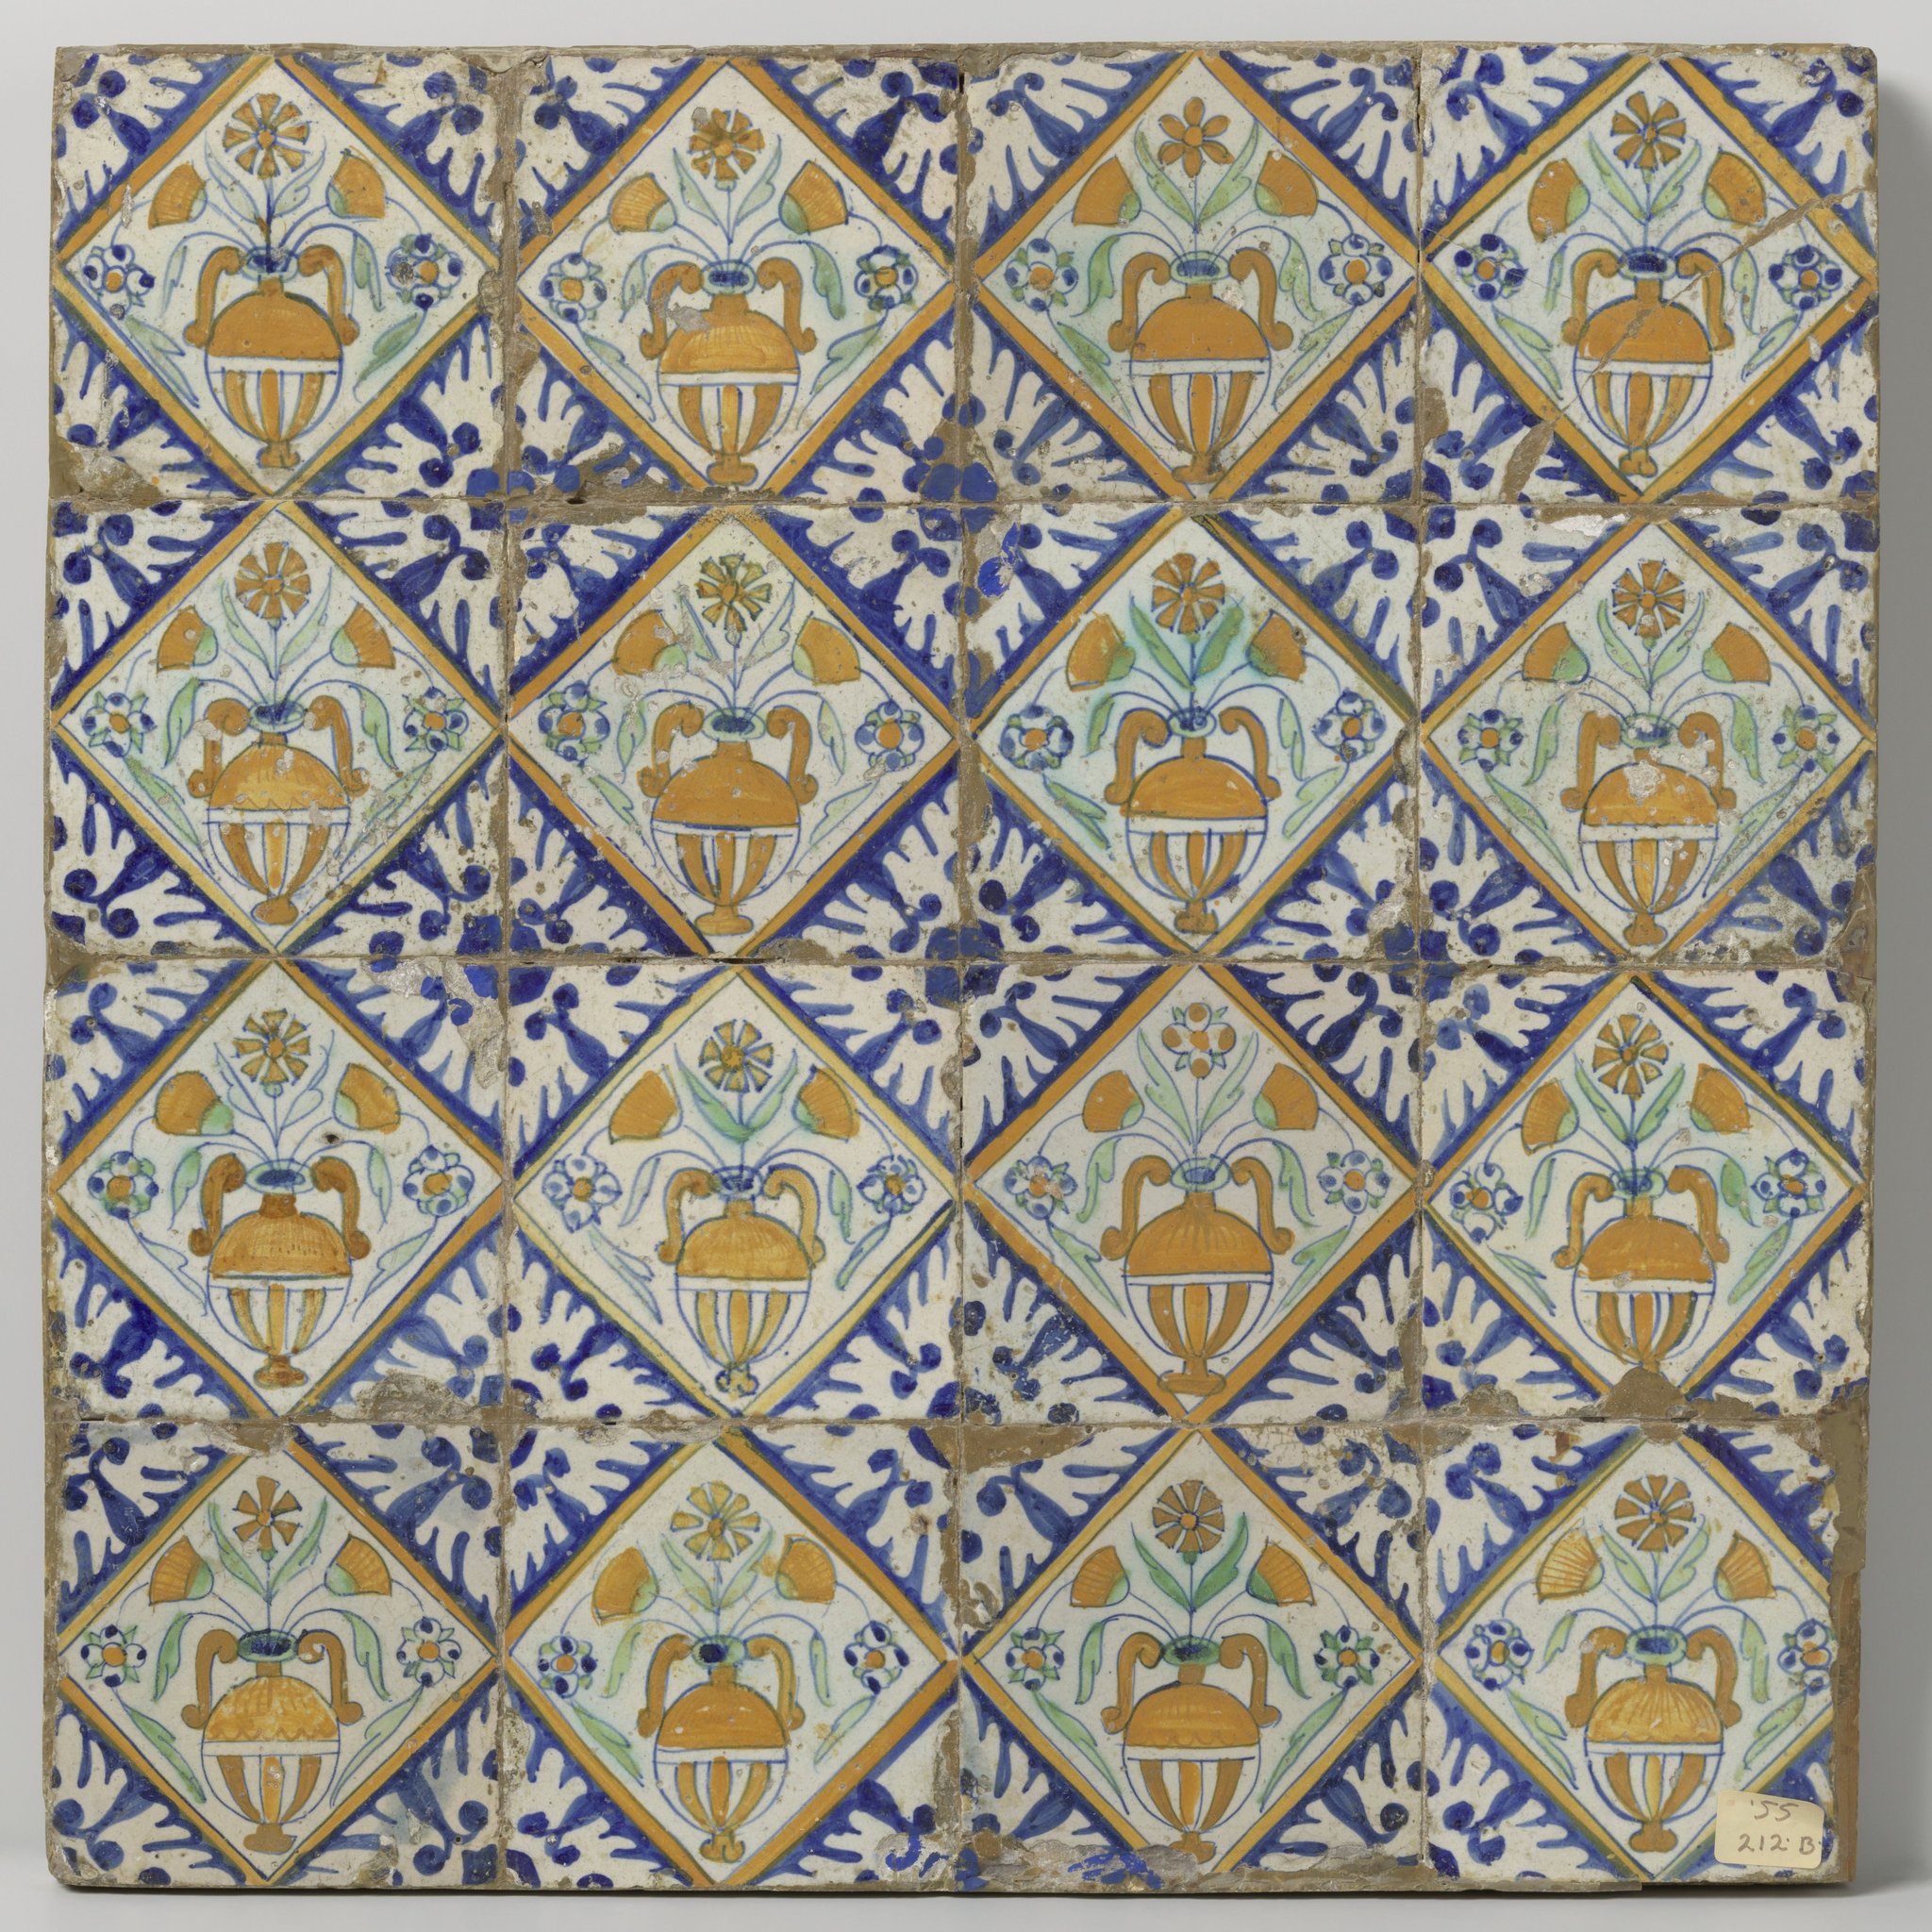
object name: tile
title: Veld van zestien tegels met bloempotten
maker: Anonymous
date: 1580-1625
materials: earthenware, glaze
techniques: maiolica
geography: netherlands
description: Veld van zestien tegels (4 x 4) elk met een veelkleurige (blauw, oranje, groen en geel) bloempot binnen een kwadraat omlijsting. In de hoeken, ornament in vultechniek.